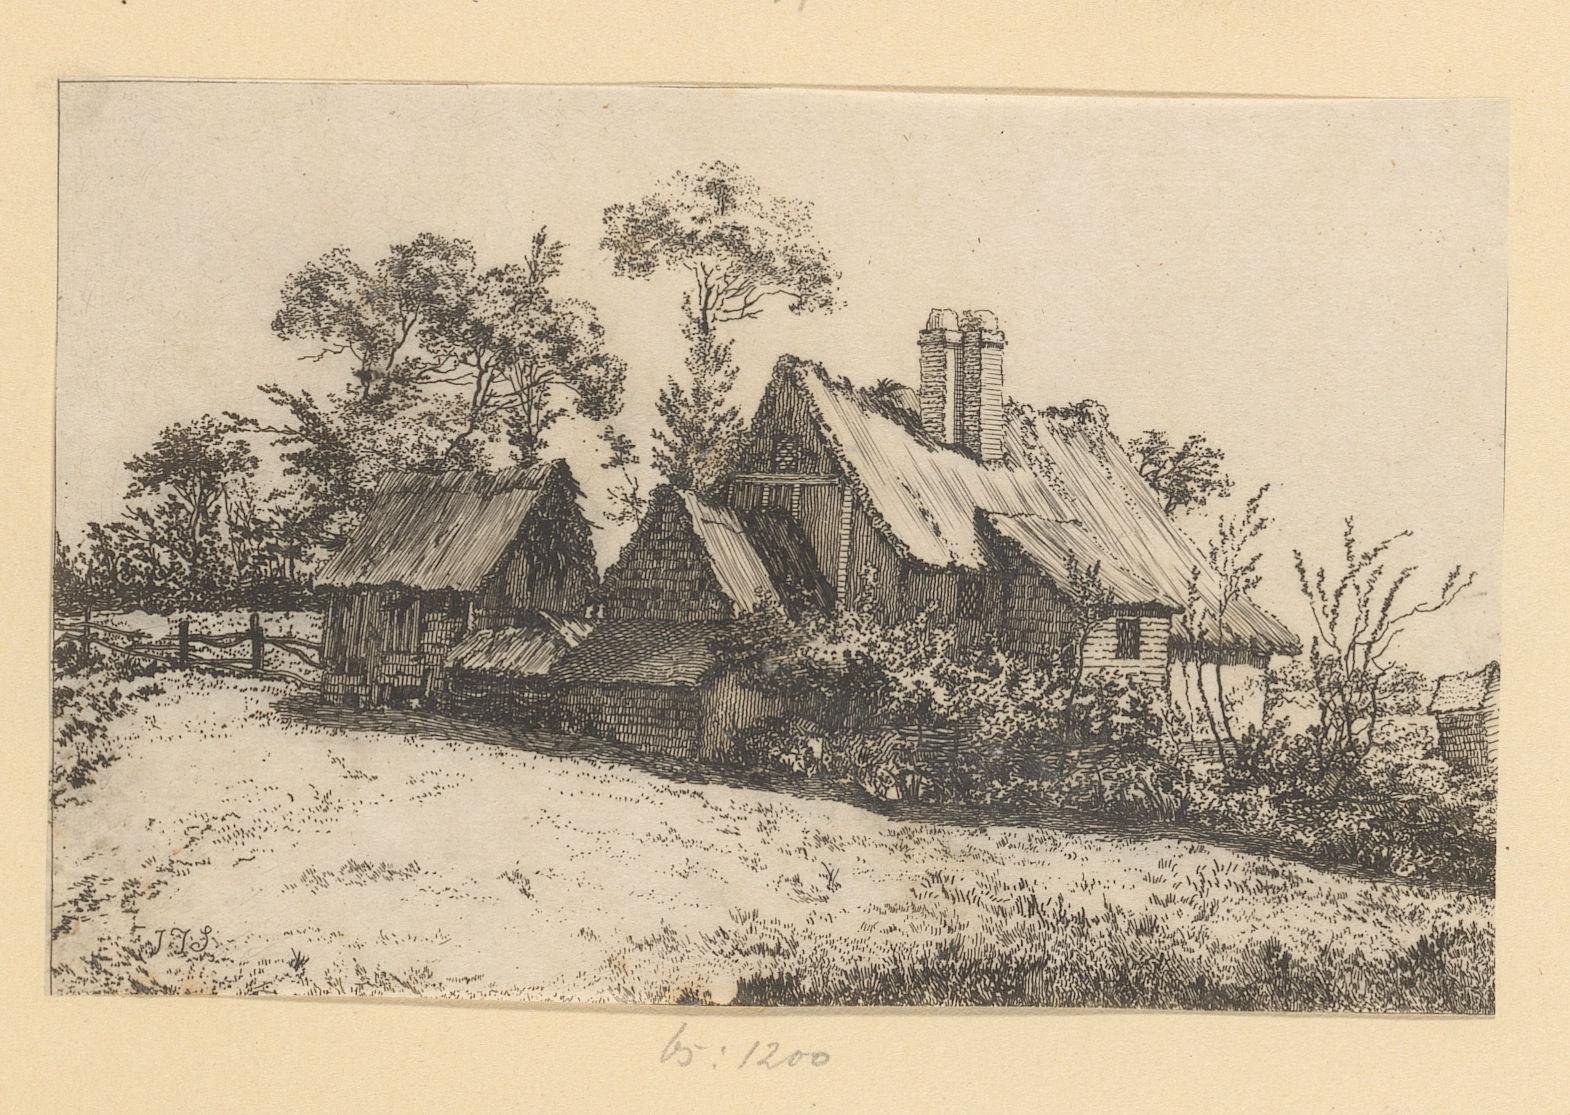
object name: print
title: Twenty rural landscapes from nature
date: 1793-1795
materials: paper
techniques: etching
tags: landscapes (+ landscape with figures, staffage), farm (building)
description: Deze prent hoort bij een serie van 20 prenten. Prent maakt mogelijk deel uit van een serie van 200 prenten. Deze serie is onder de titel 'A Collection of two hundred original etchings' voor het eerst uitgegeven door J.M. Greery in 1816.